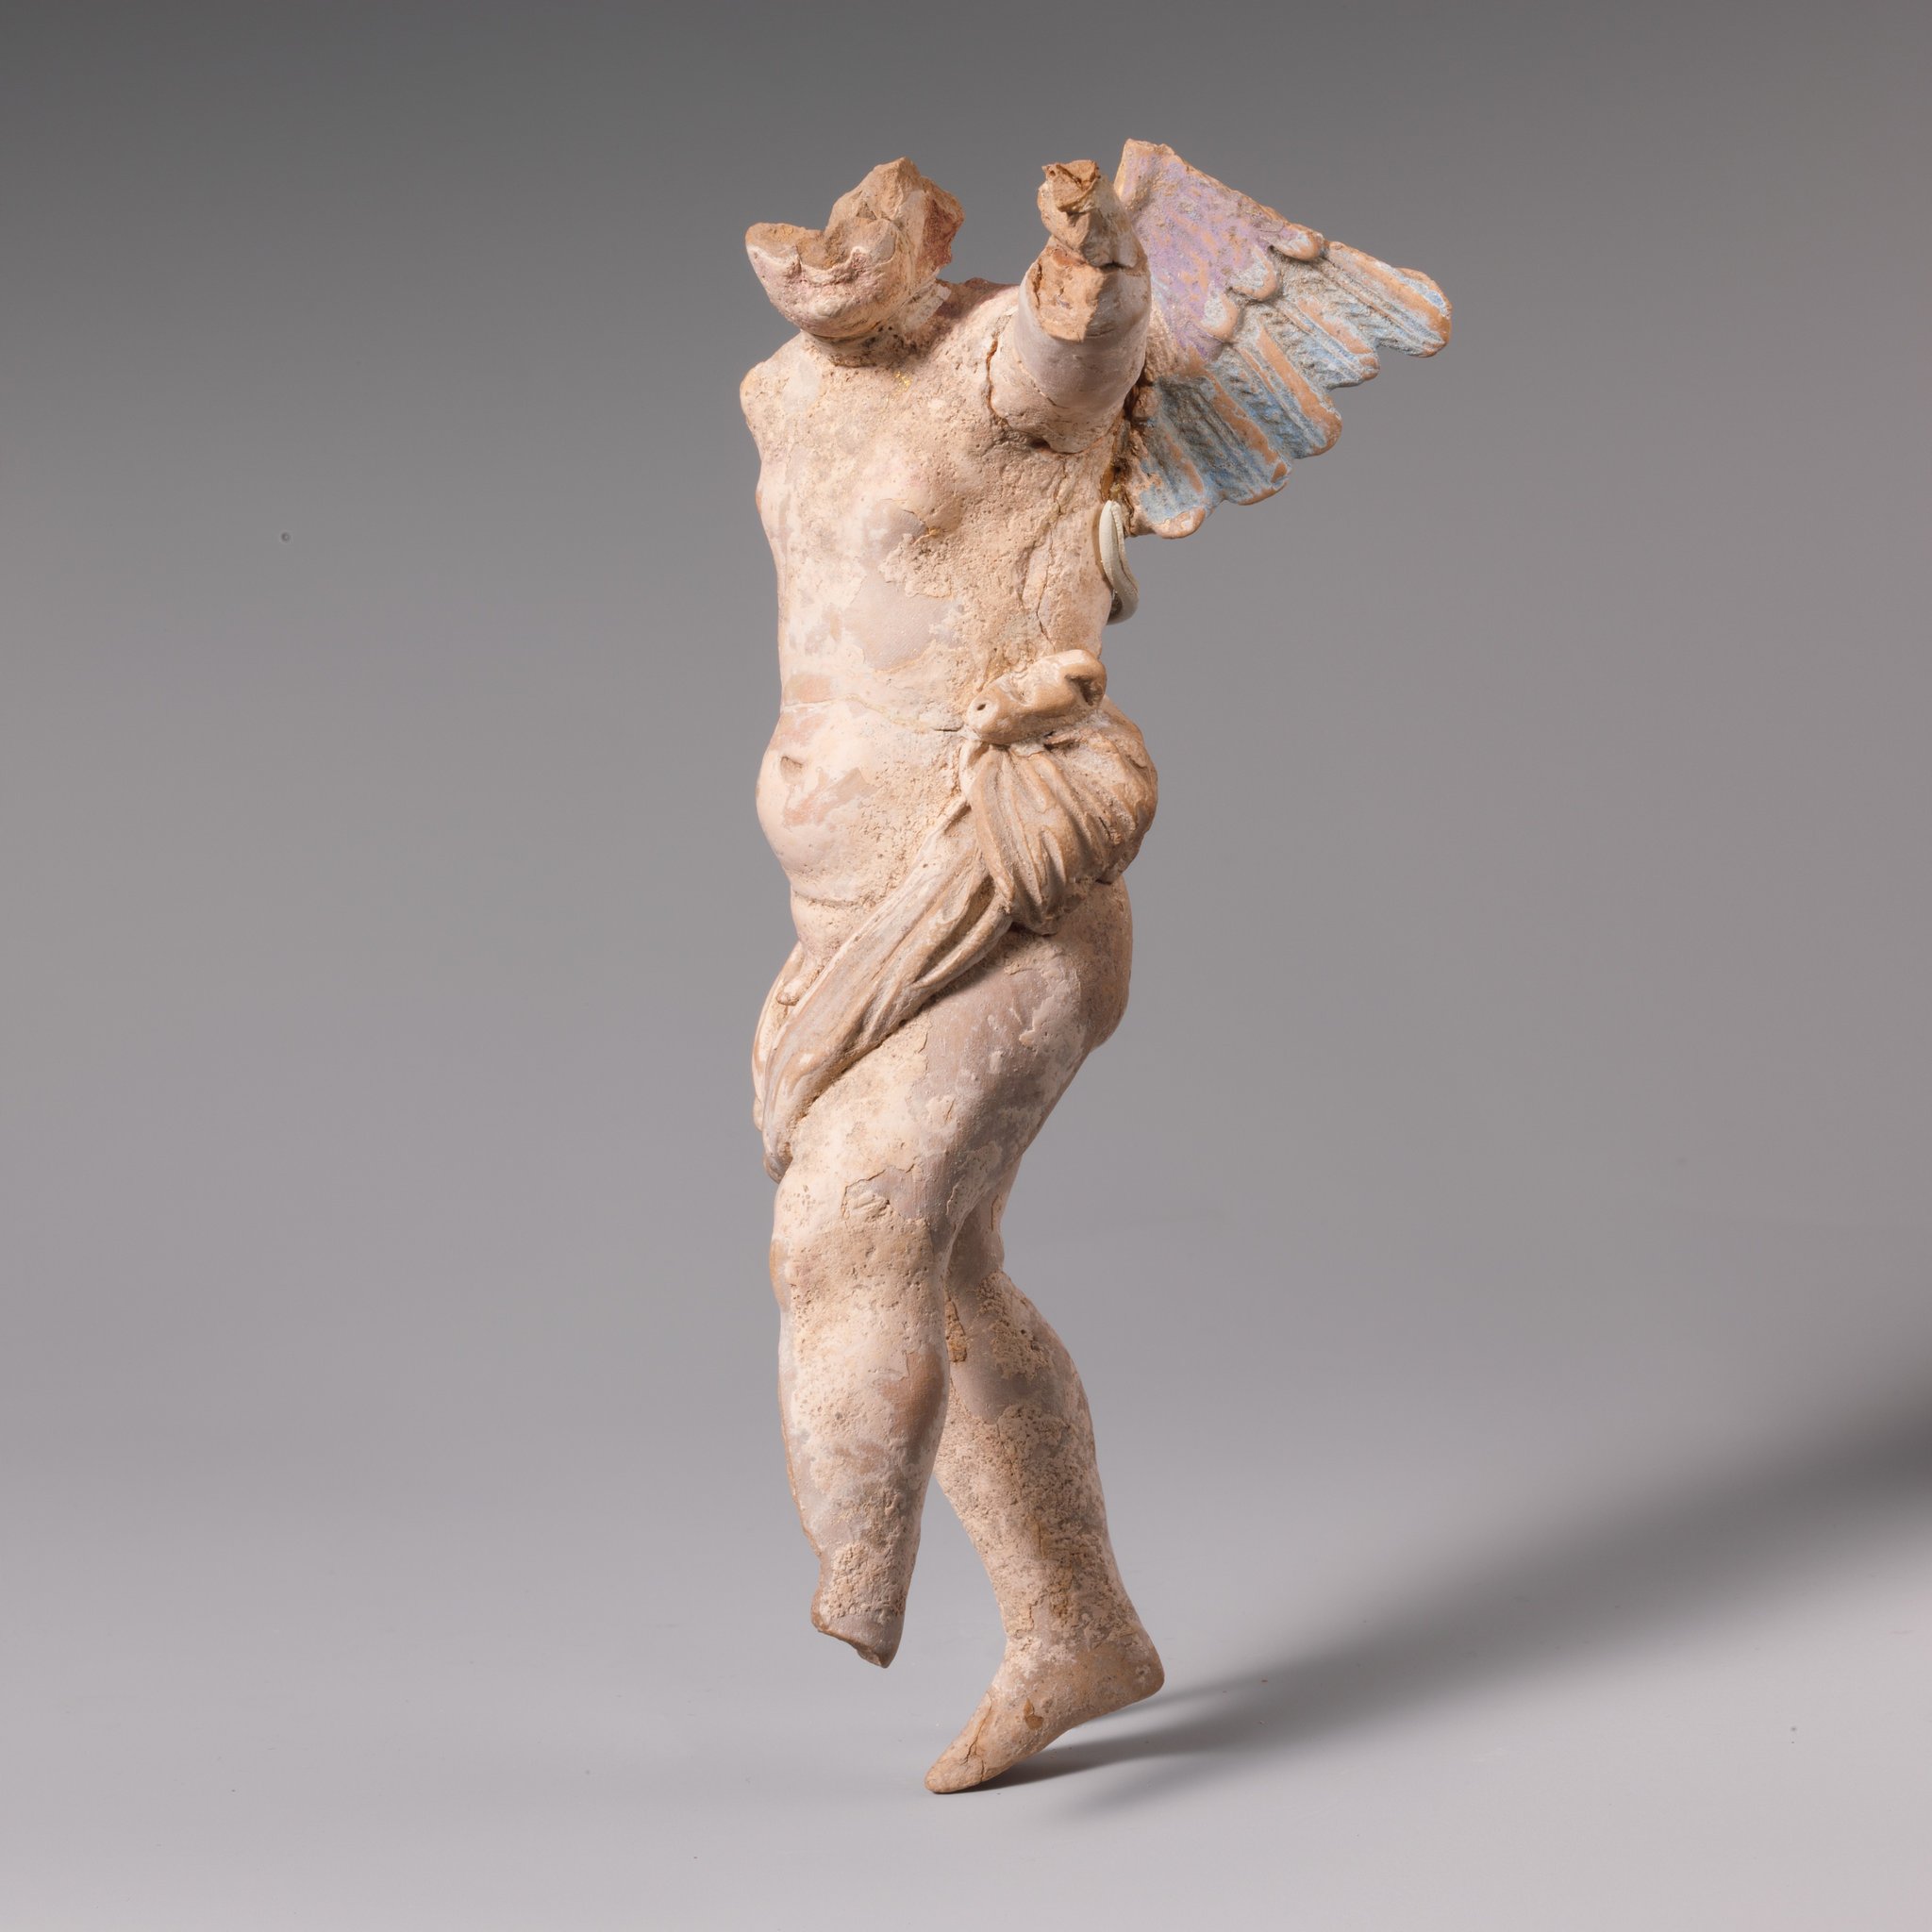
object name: statuette of eros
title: Terracotta statuette of Eros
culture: greek, south italian, tarentine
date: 300-201 BCE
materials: terracotta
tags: eros